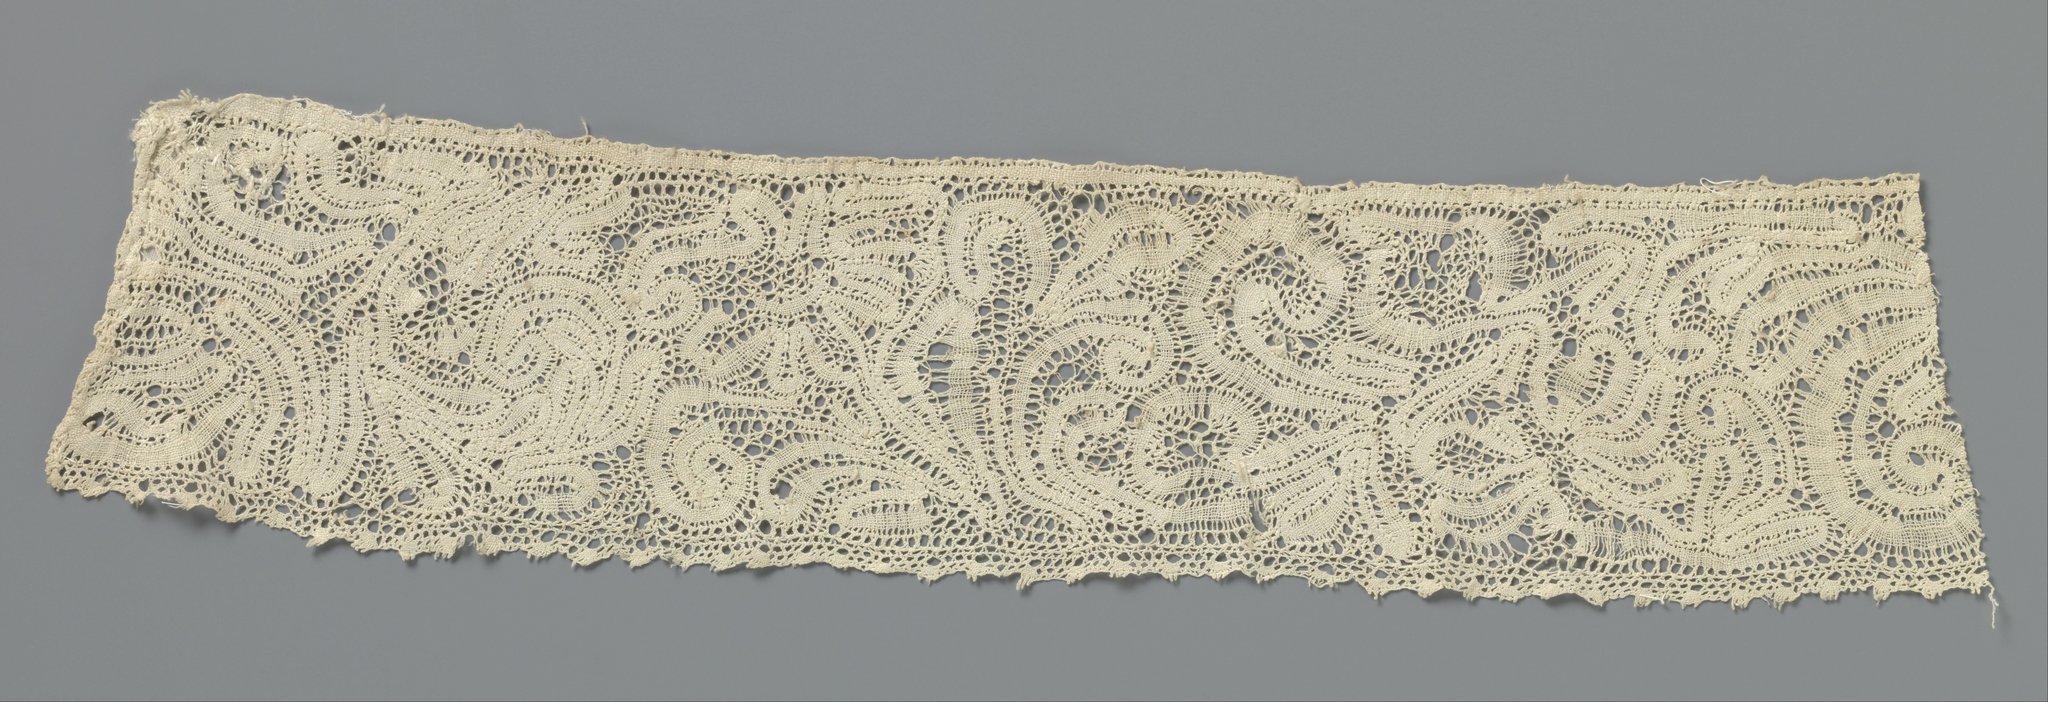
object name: strip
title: Strook kloskant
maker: Anonymous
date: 1800-1899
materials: linen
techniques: lace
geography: eastern europe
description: Strook naturelkleurige kloskant, Oosteuropese kant. Het patroon wordt gevormd door gekloste linten, die al kronkelend organische vormen creeëren, die uit elkaar voortkomen en in elkaar overgaan. Te onderscheiden zijn verschillende voluutbladeren en een enkele bloemkelk, waaronder een margriet of zonnehoed. De linten zijn gemaakt in linnenslag met opengewerkte randjes. De meeste ruimte wordt ingenomen door de linten, verbindingen zijn onder andere gemaakt met overstekende paren en met enkele mazen gemaakt, waaronder ronde Valenciennes-mazen. De bovenzijde is afgewerkt met een recht geklost lint, met opengewerkte randjes aan beide zijden. Langs de onderzijde zorgt een afwisseling van enkele mazen en steeds één klein waaiervormig motiefje met picots voor een schulpenrand met kleine schulpjes.